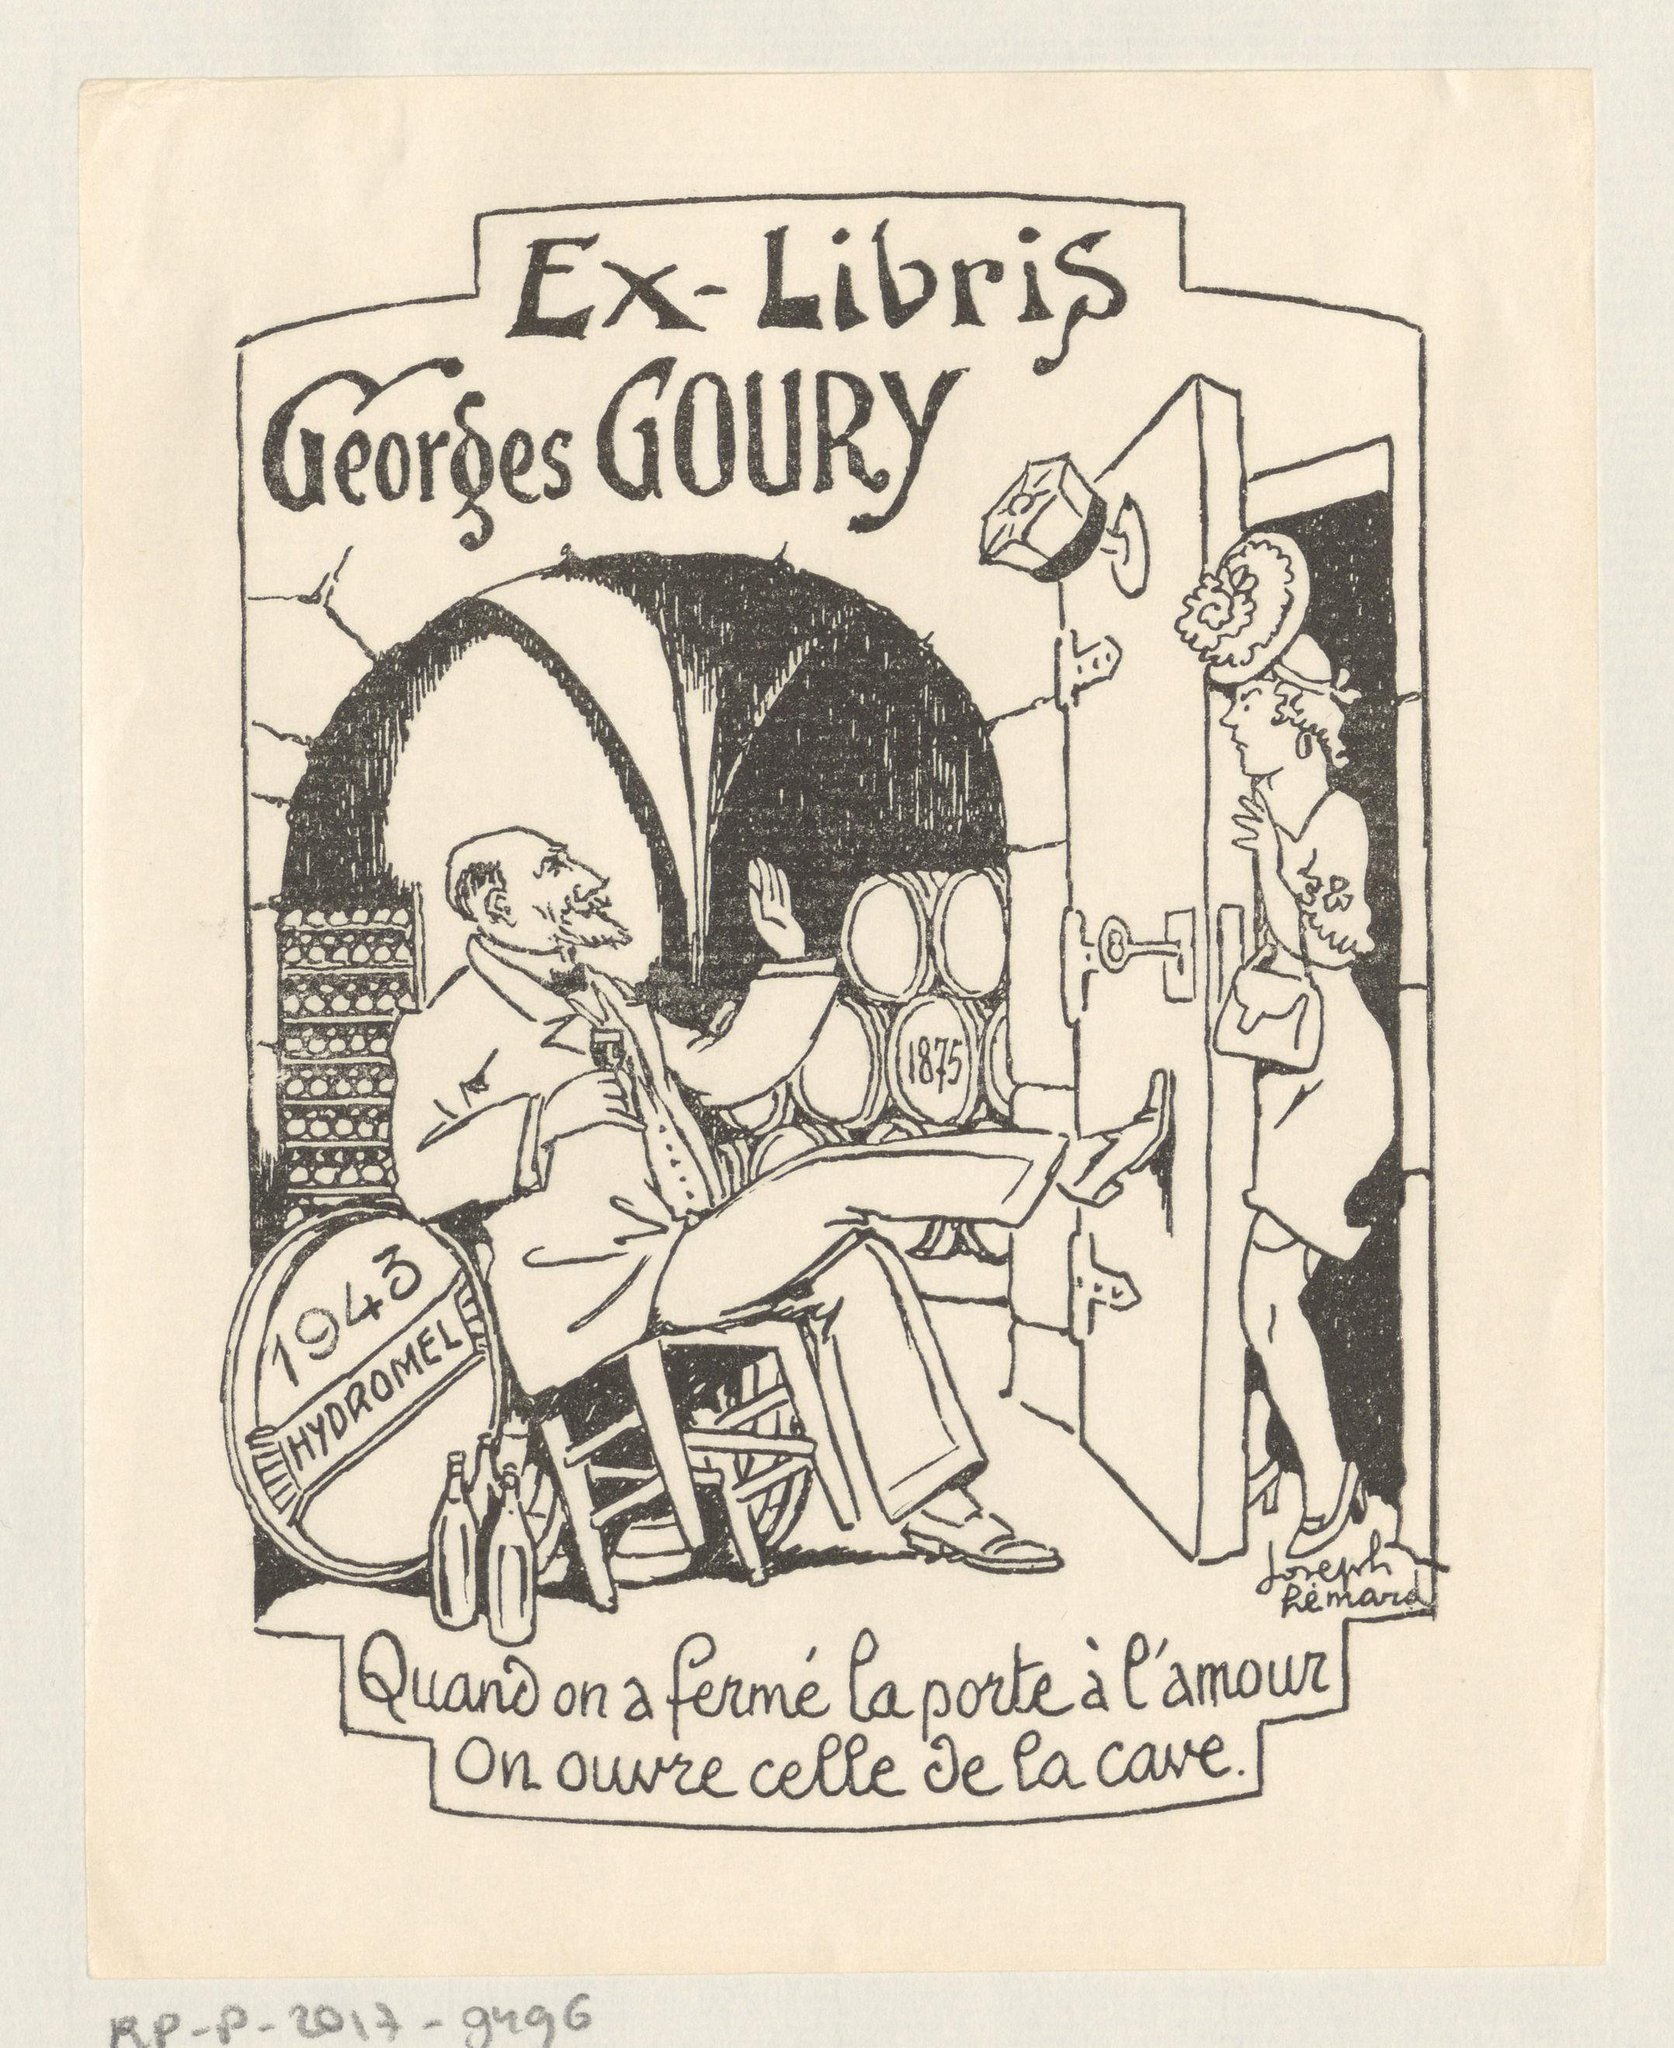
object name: bookplate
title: Quand on a fermé la porte à l'amour, on ouvre celle de la cave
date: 1943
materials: paper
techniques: printing block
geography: france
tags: wine-cellar, sitting figure, old man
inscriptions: date